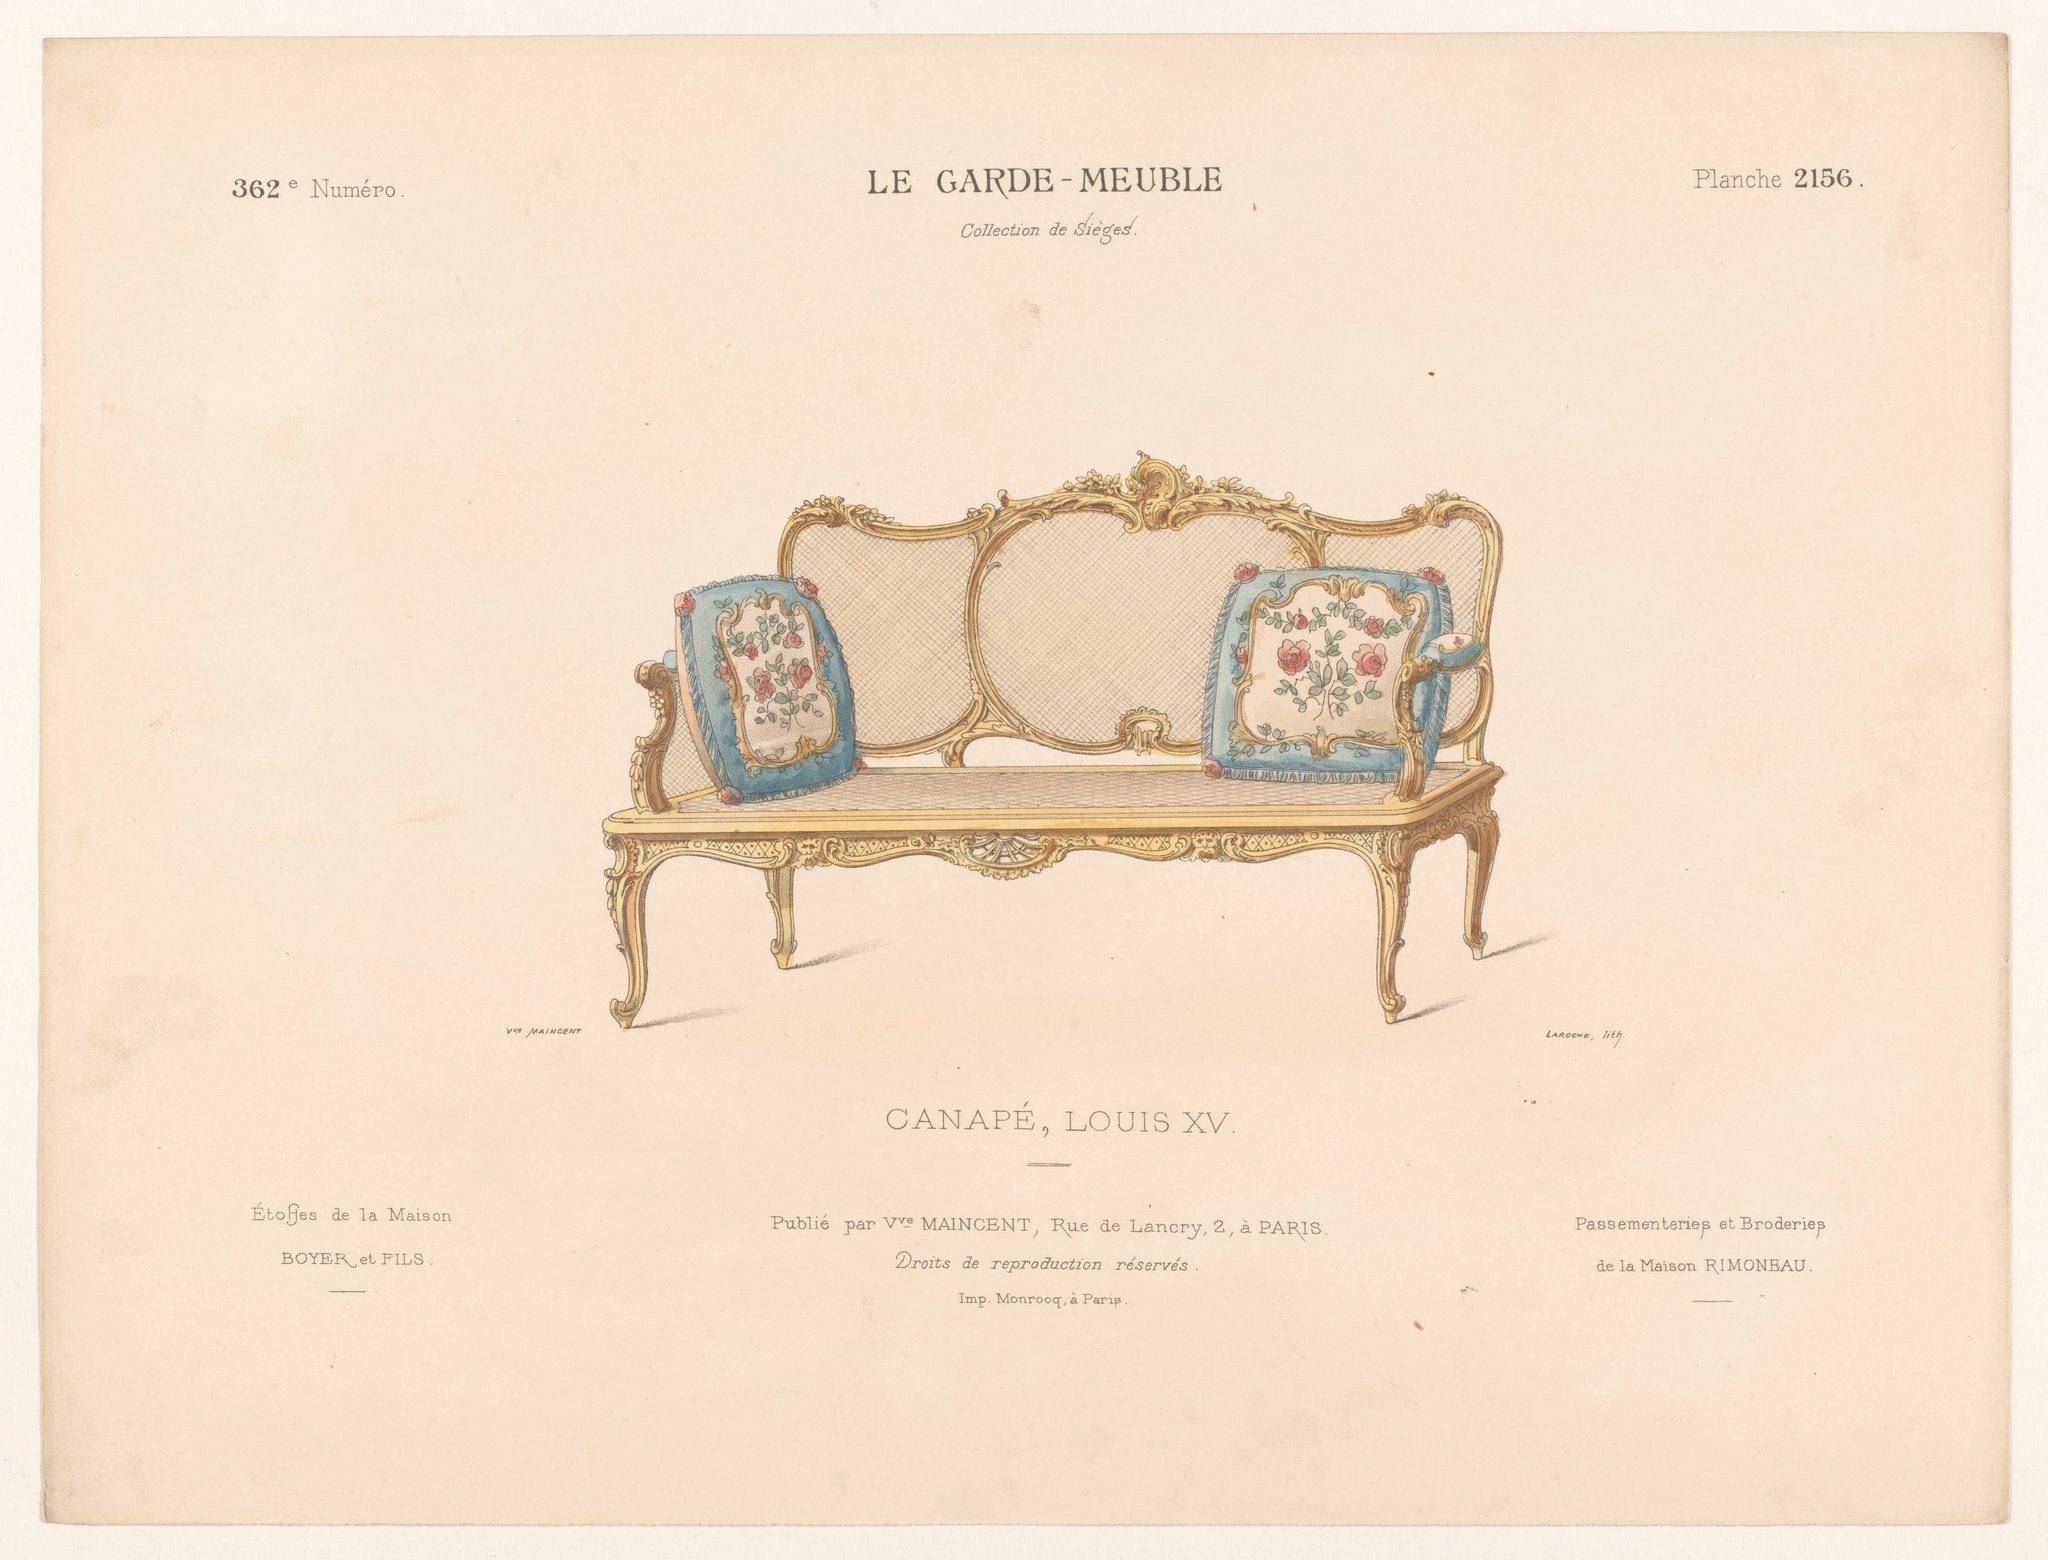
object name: print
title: Canapé, Louis XV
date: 1895-1935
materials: paper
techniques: hand coloring, lithograph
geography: paris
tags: seating furniture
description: Ieder Livraison in de serie Le Garde-Meuble bevat negen platen: drie 'sièges' (zitmeubels), drie 'meubles' (diverse meubels zoals tafels en kasten) en drie 'tentures' (gordijnen en draperieën).